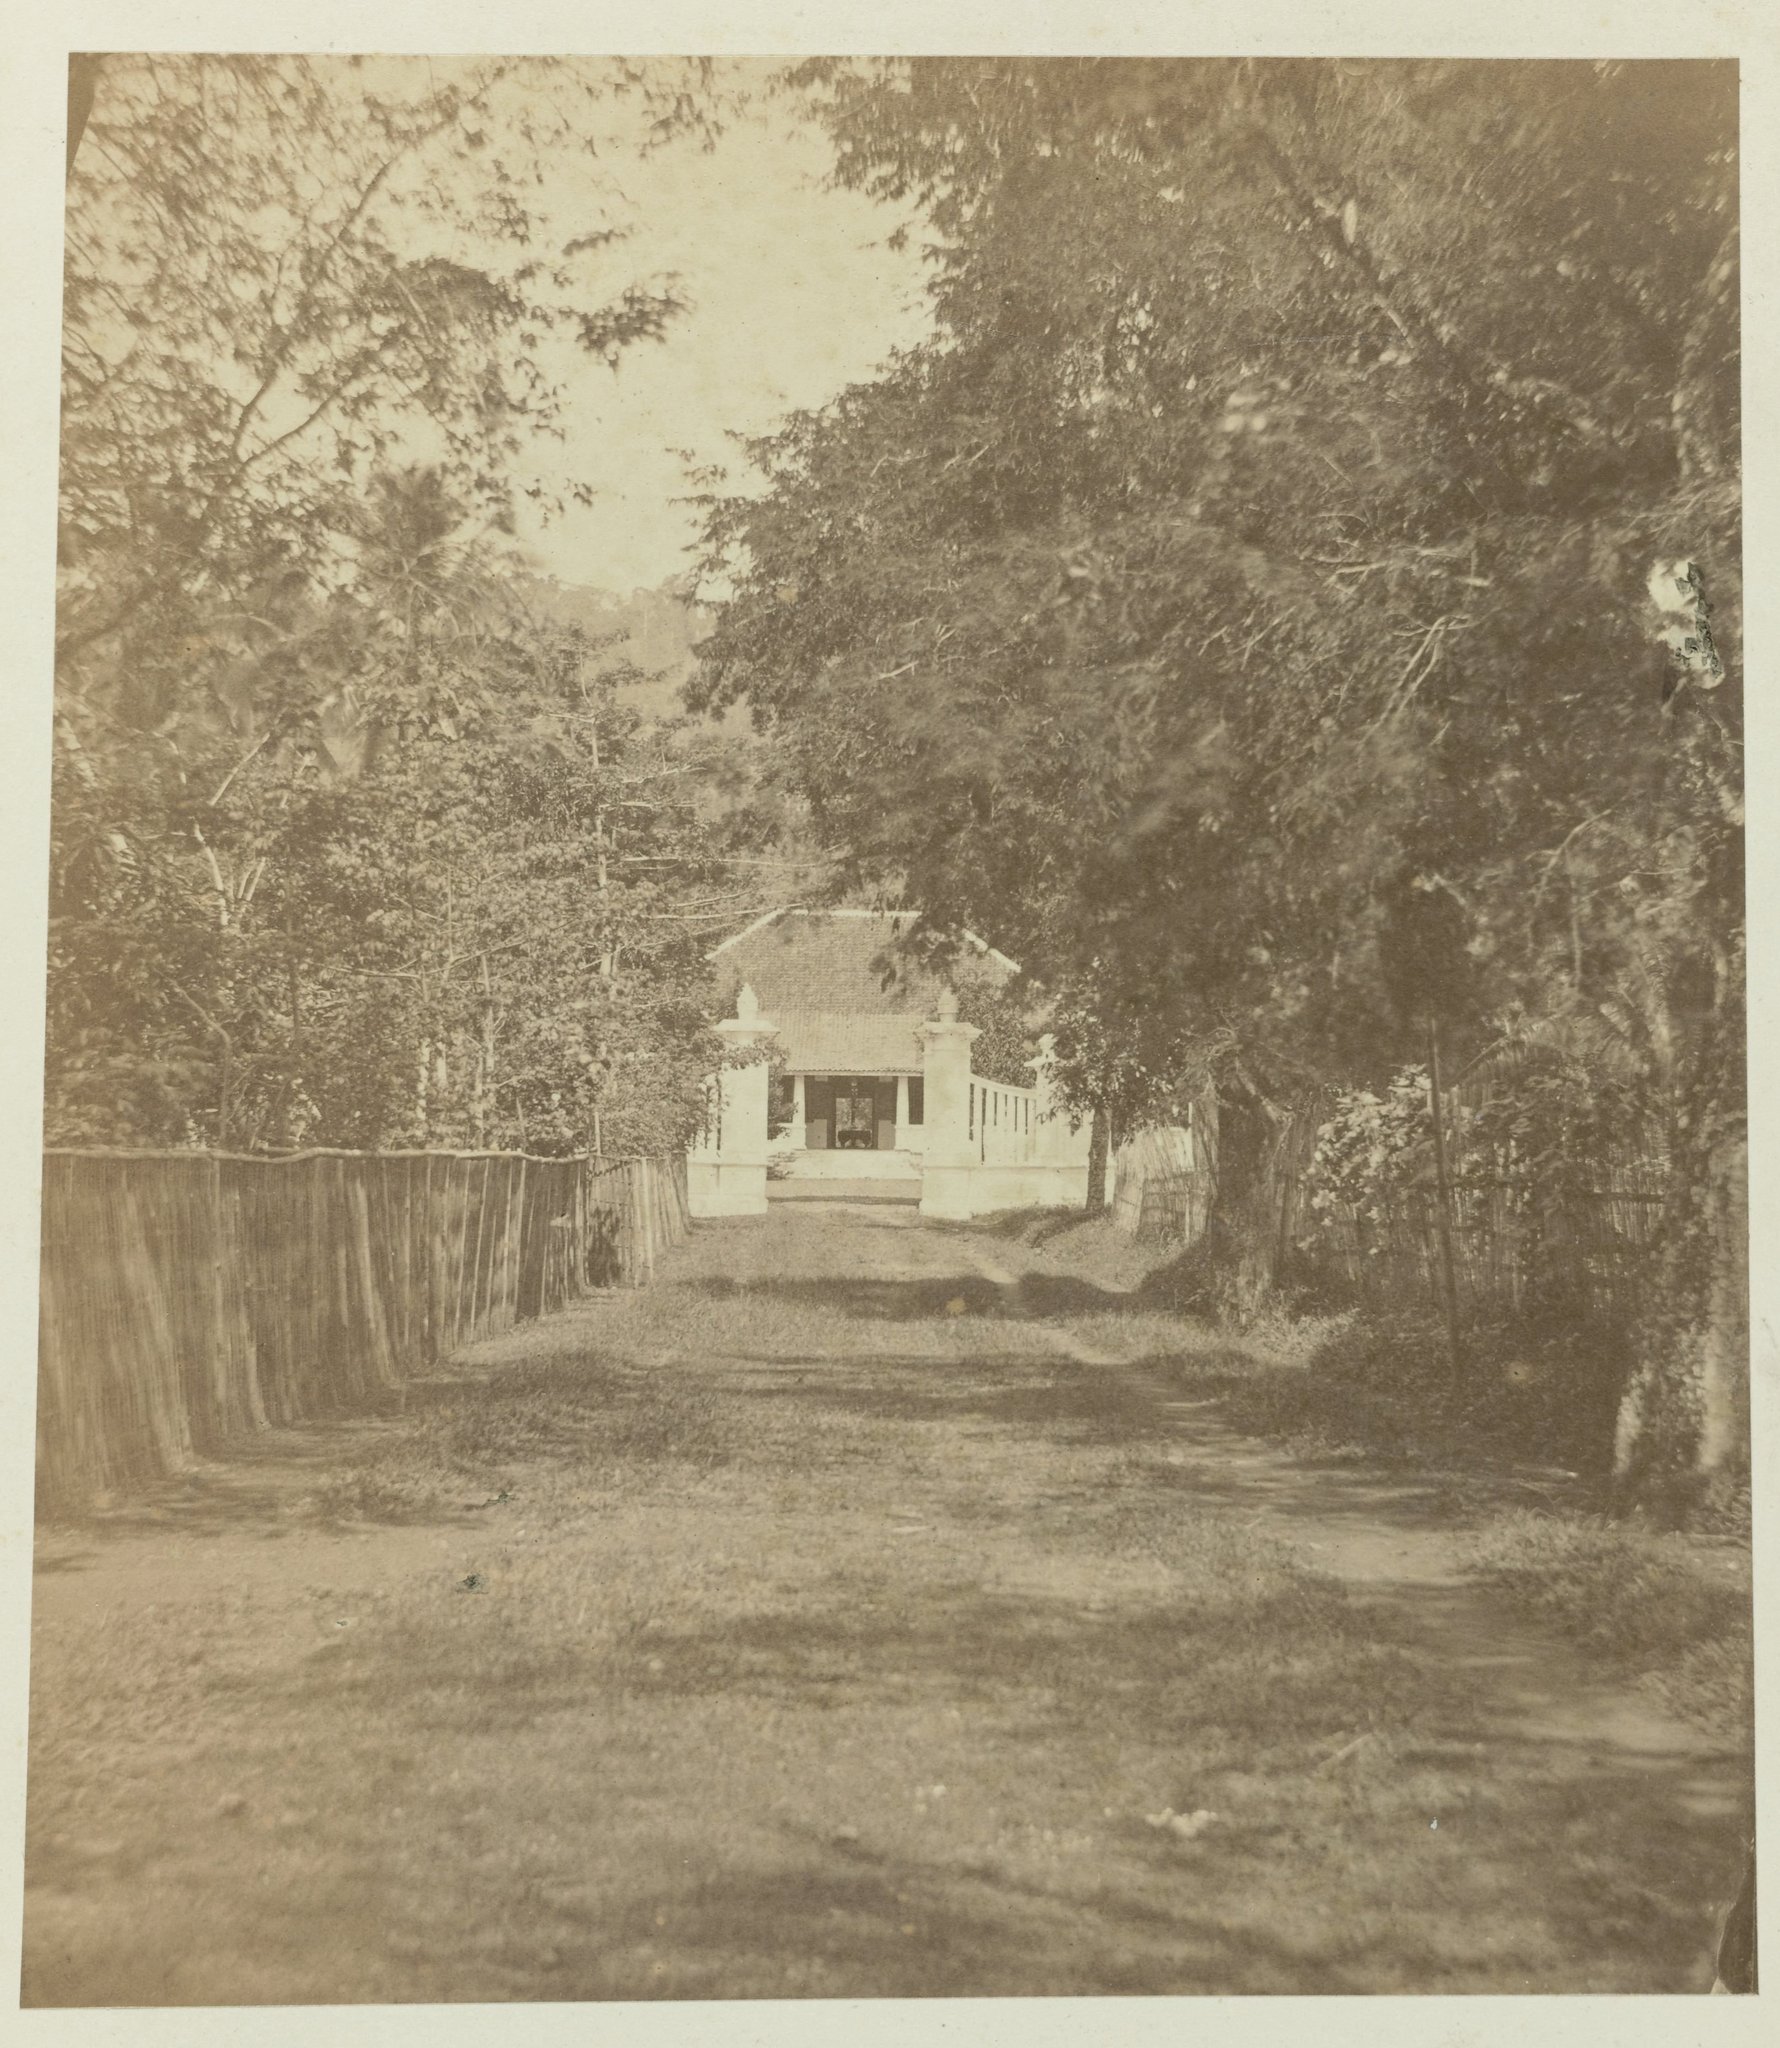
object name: photograph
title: Weg naar een huis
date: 1863-1869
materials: photographic support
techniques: albumen print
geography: java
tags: country-house, java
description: Weg naar een huis met een wit hek. Onderdeel van het groene fotoalbum met foto's van Java, uit het bezit van apotheker Specht-Grijp, die in 1865 vanuit Batavia naar Nederland terugkeerde.